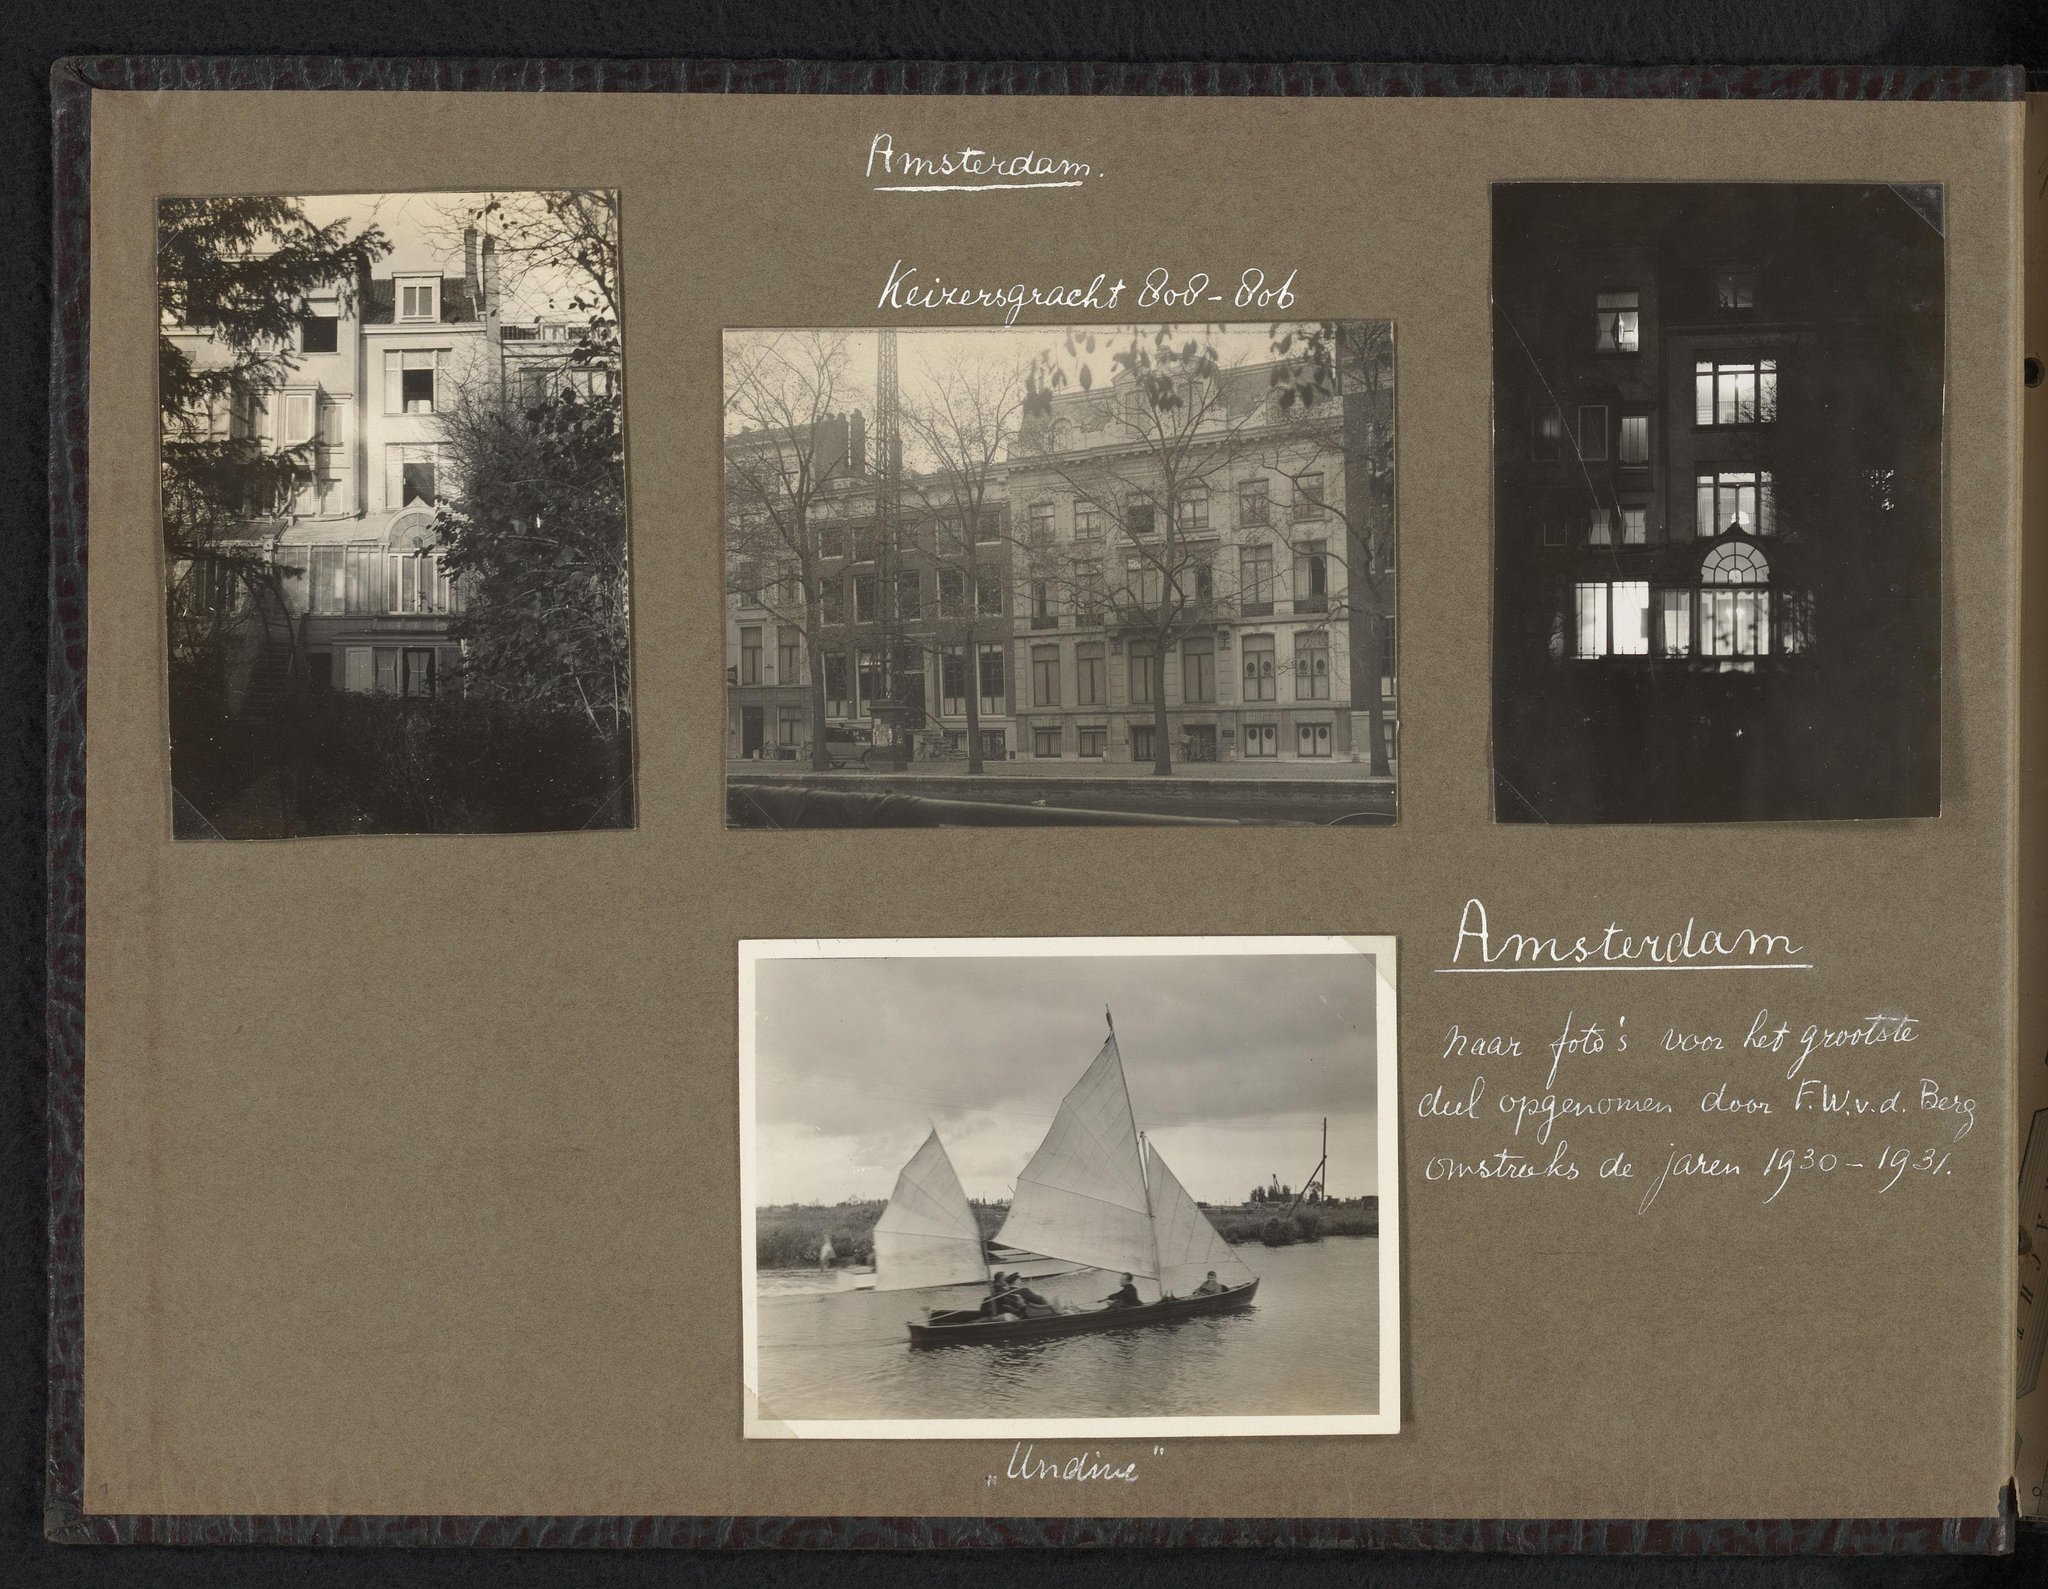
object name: photograph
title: Amsterdam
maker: frank willem van den berg (1912-1998)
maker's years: 1912-1998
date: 1930-1931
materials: paper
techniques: gelatin silver print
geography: amsterdam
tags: urban housing, sailing-ship, sailing-boat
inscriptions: inscription: ‘Amsterdam./ Keizersgracht 808-806’, inscription: ‘Amsterdam/ Naar foto's voor het grootste/ deel opgenomen door F.W. v.d. Berg/ omstreeks de jaren 1930-1931.’, inscription: ‘"Undine"’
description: Deze foto's maken deel uit van een album.